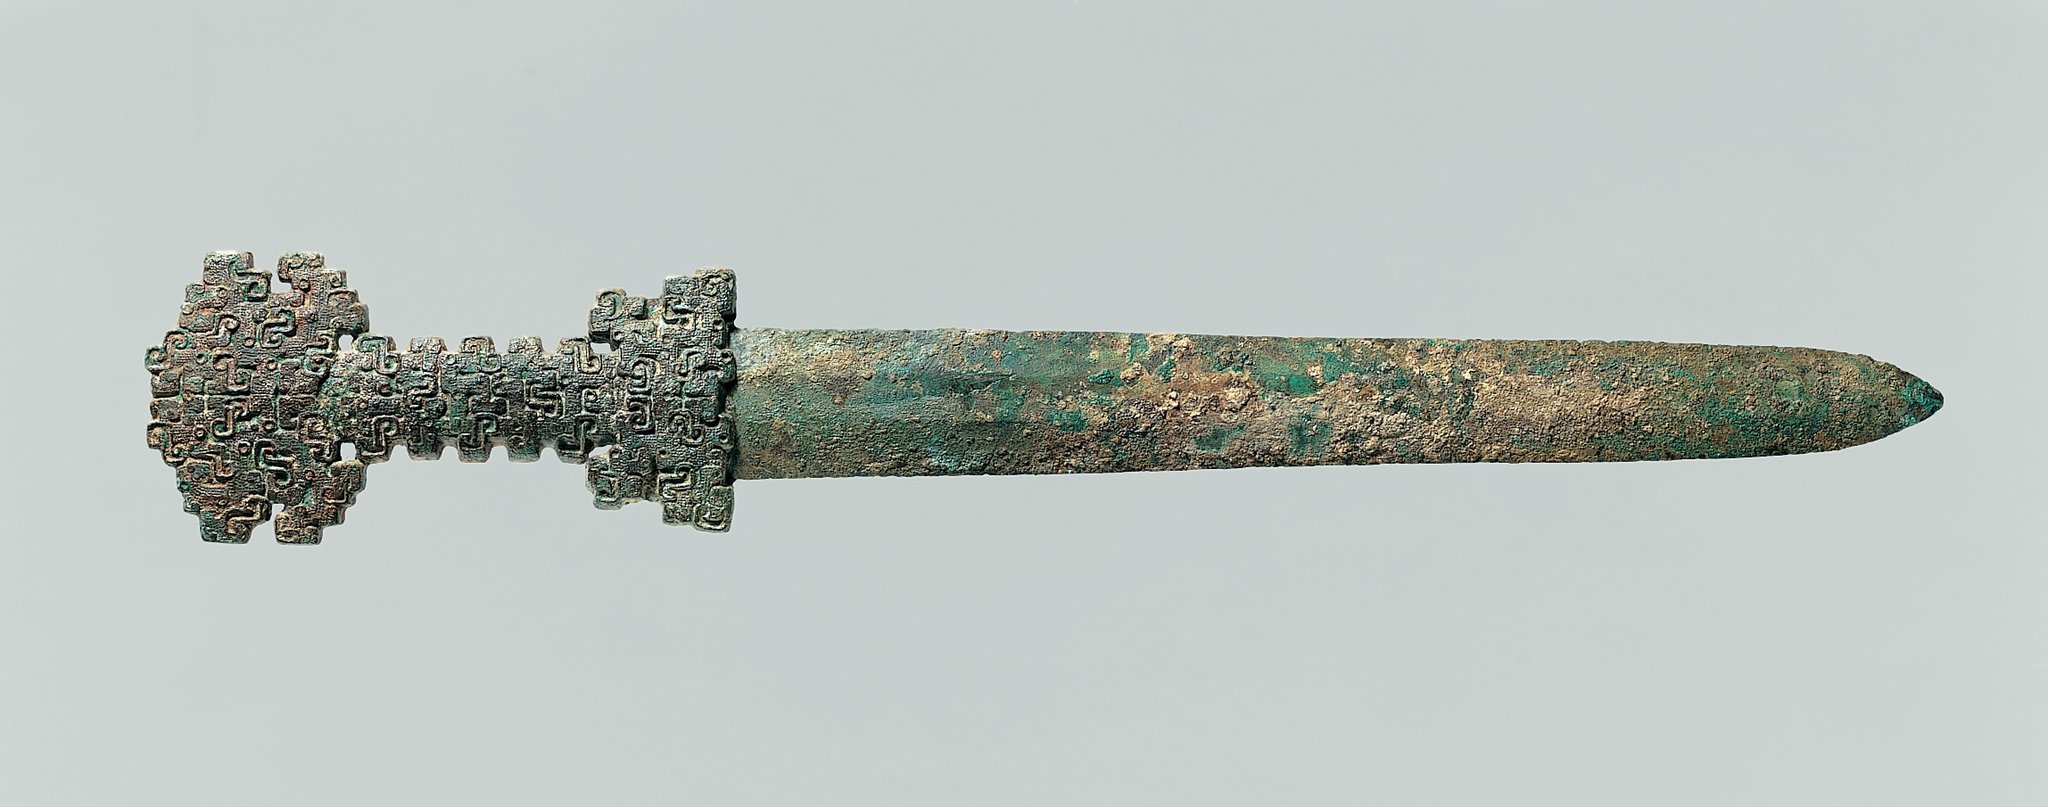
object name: short sword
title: Short Sword with Ornate Handle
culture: north chinese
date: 600-401 BCE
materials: bronze